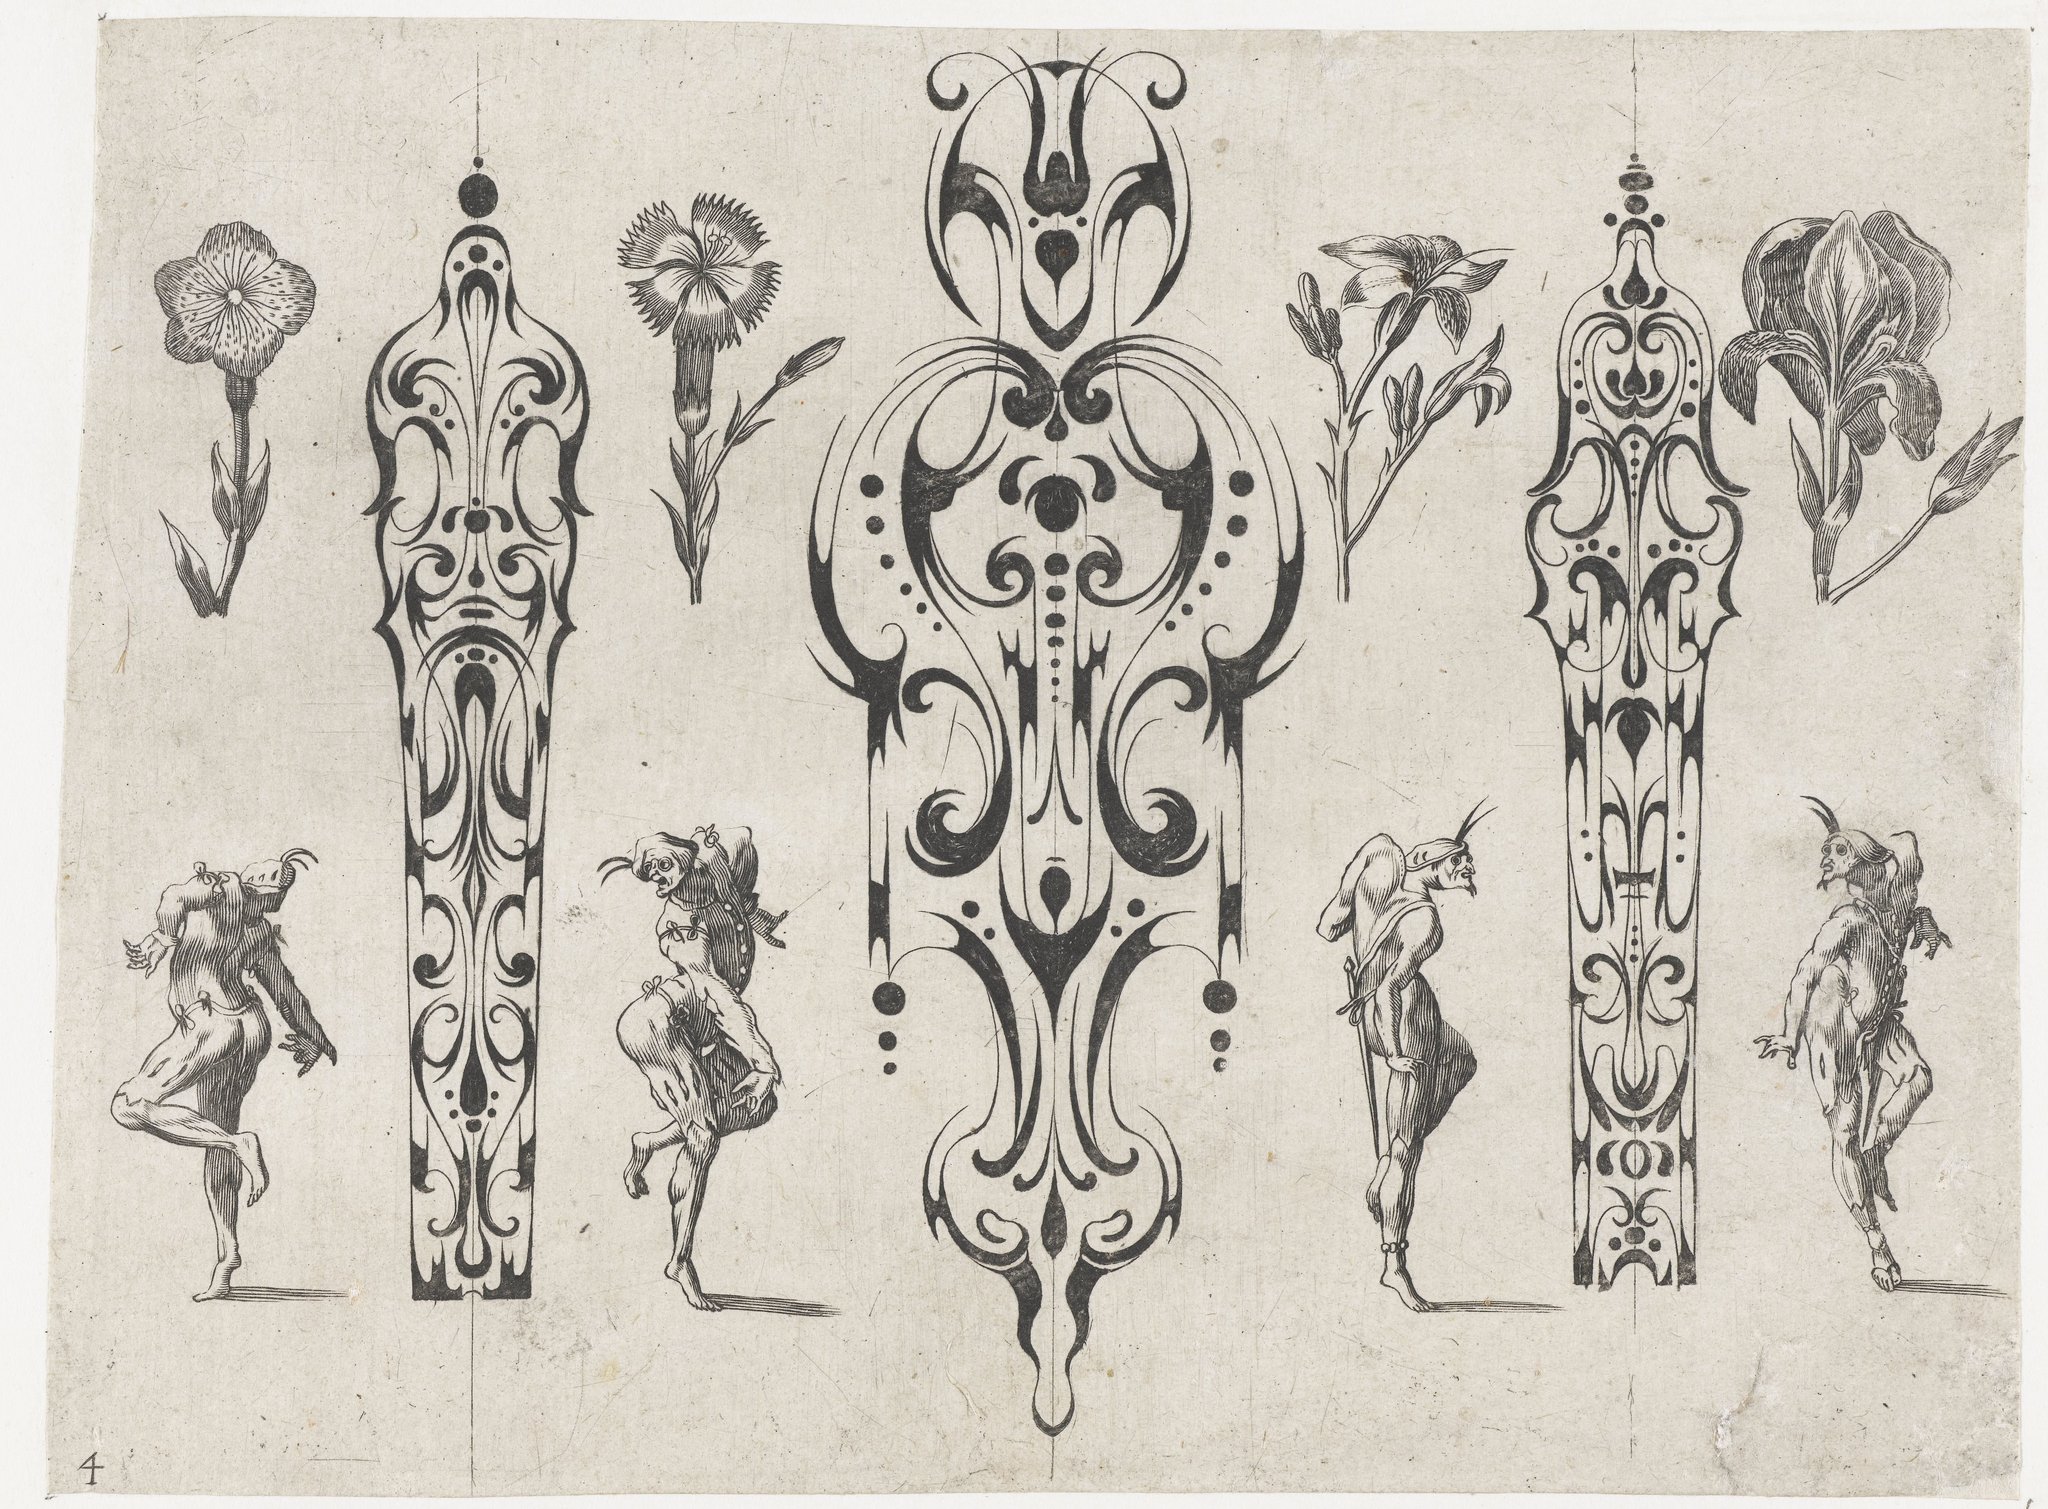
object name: ornament print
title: Drie langwerpige Schweifwerk ornamenten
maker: meynert jelissen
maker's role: print maker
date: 1622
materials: paper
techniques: engraving, etching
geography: groningen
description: Bovenaan vier bloemen, onderaan vier dansende Commedia dell'arte figuren (naar Callot)